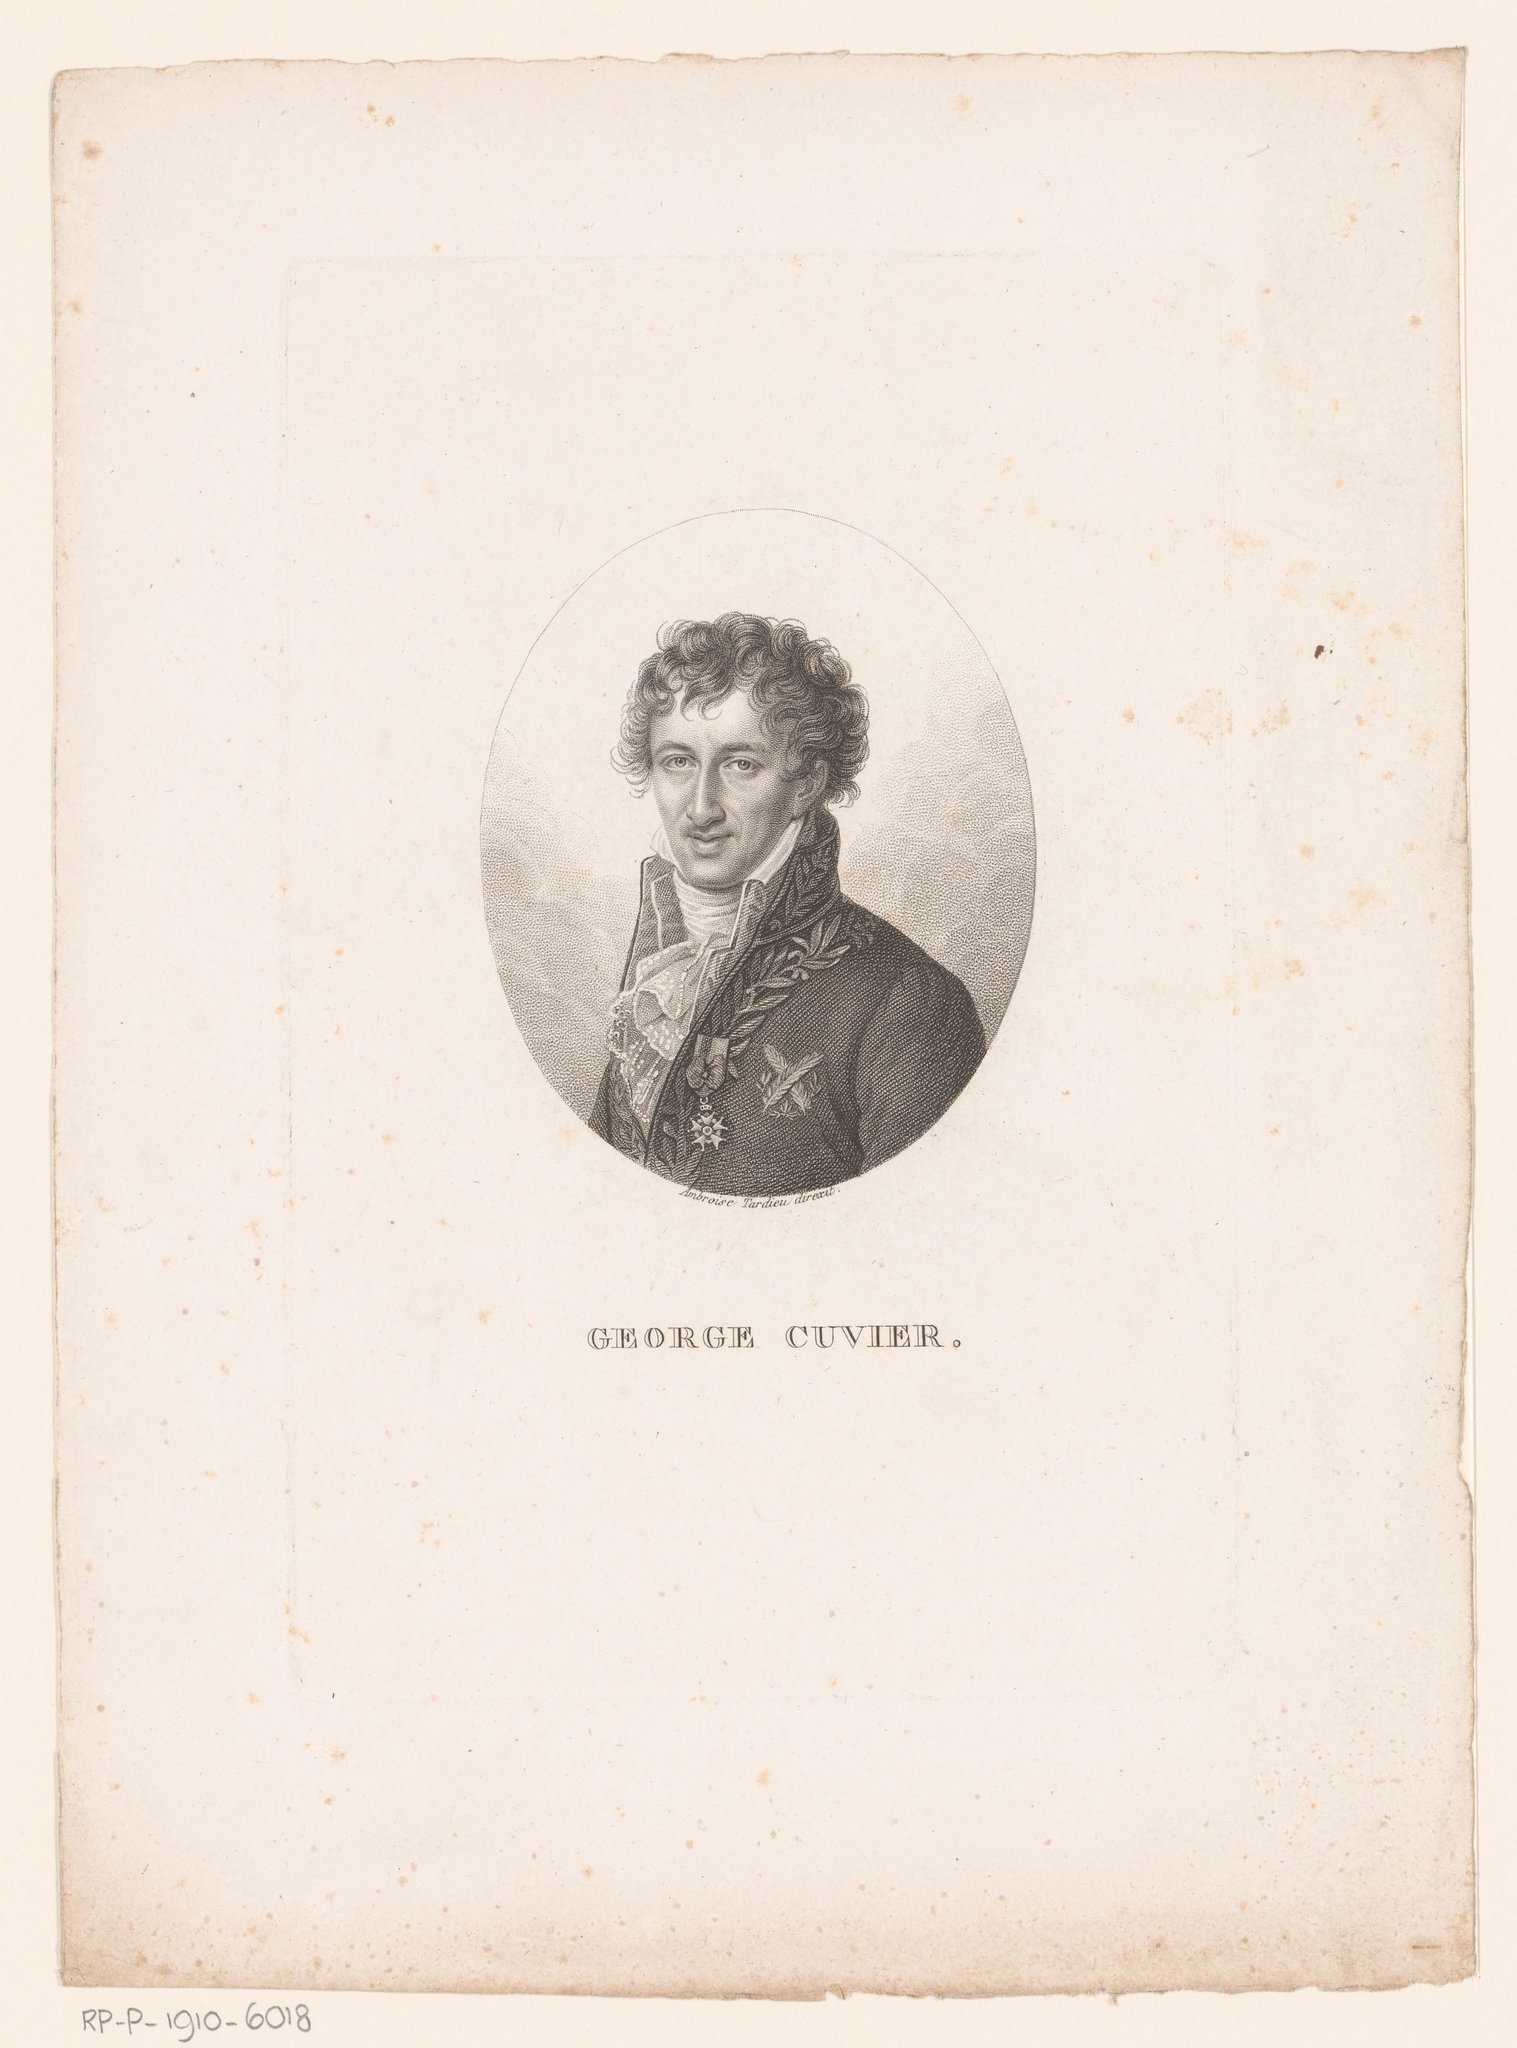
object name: print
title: Portret van Georges Cuvier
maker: ambroise tardieu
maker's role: print maker, printer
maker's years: 1788-1841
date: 1820-1828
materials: paper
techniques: engraving, roulette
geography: paris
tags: paris, historical persons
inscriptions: collector's mark: Lugt 2228